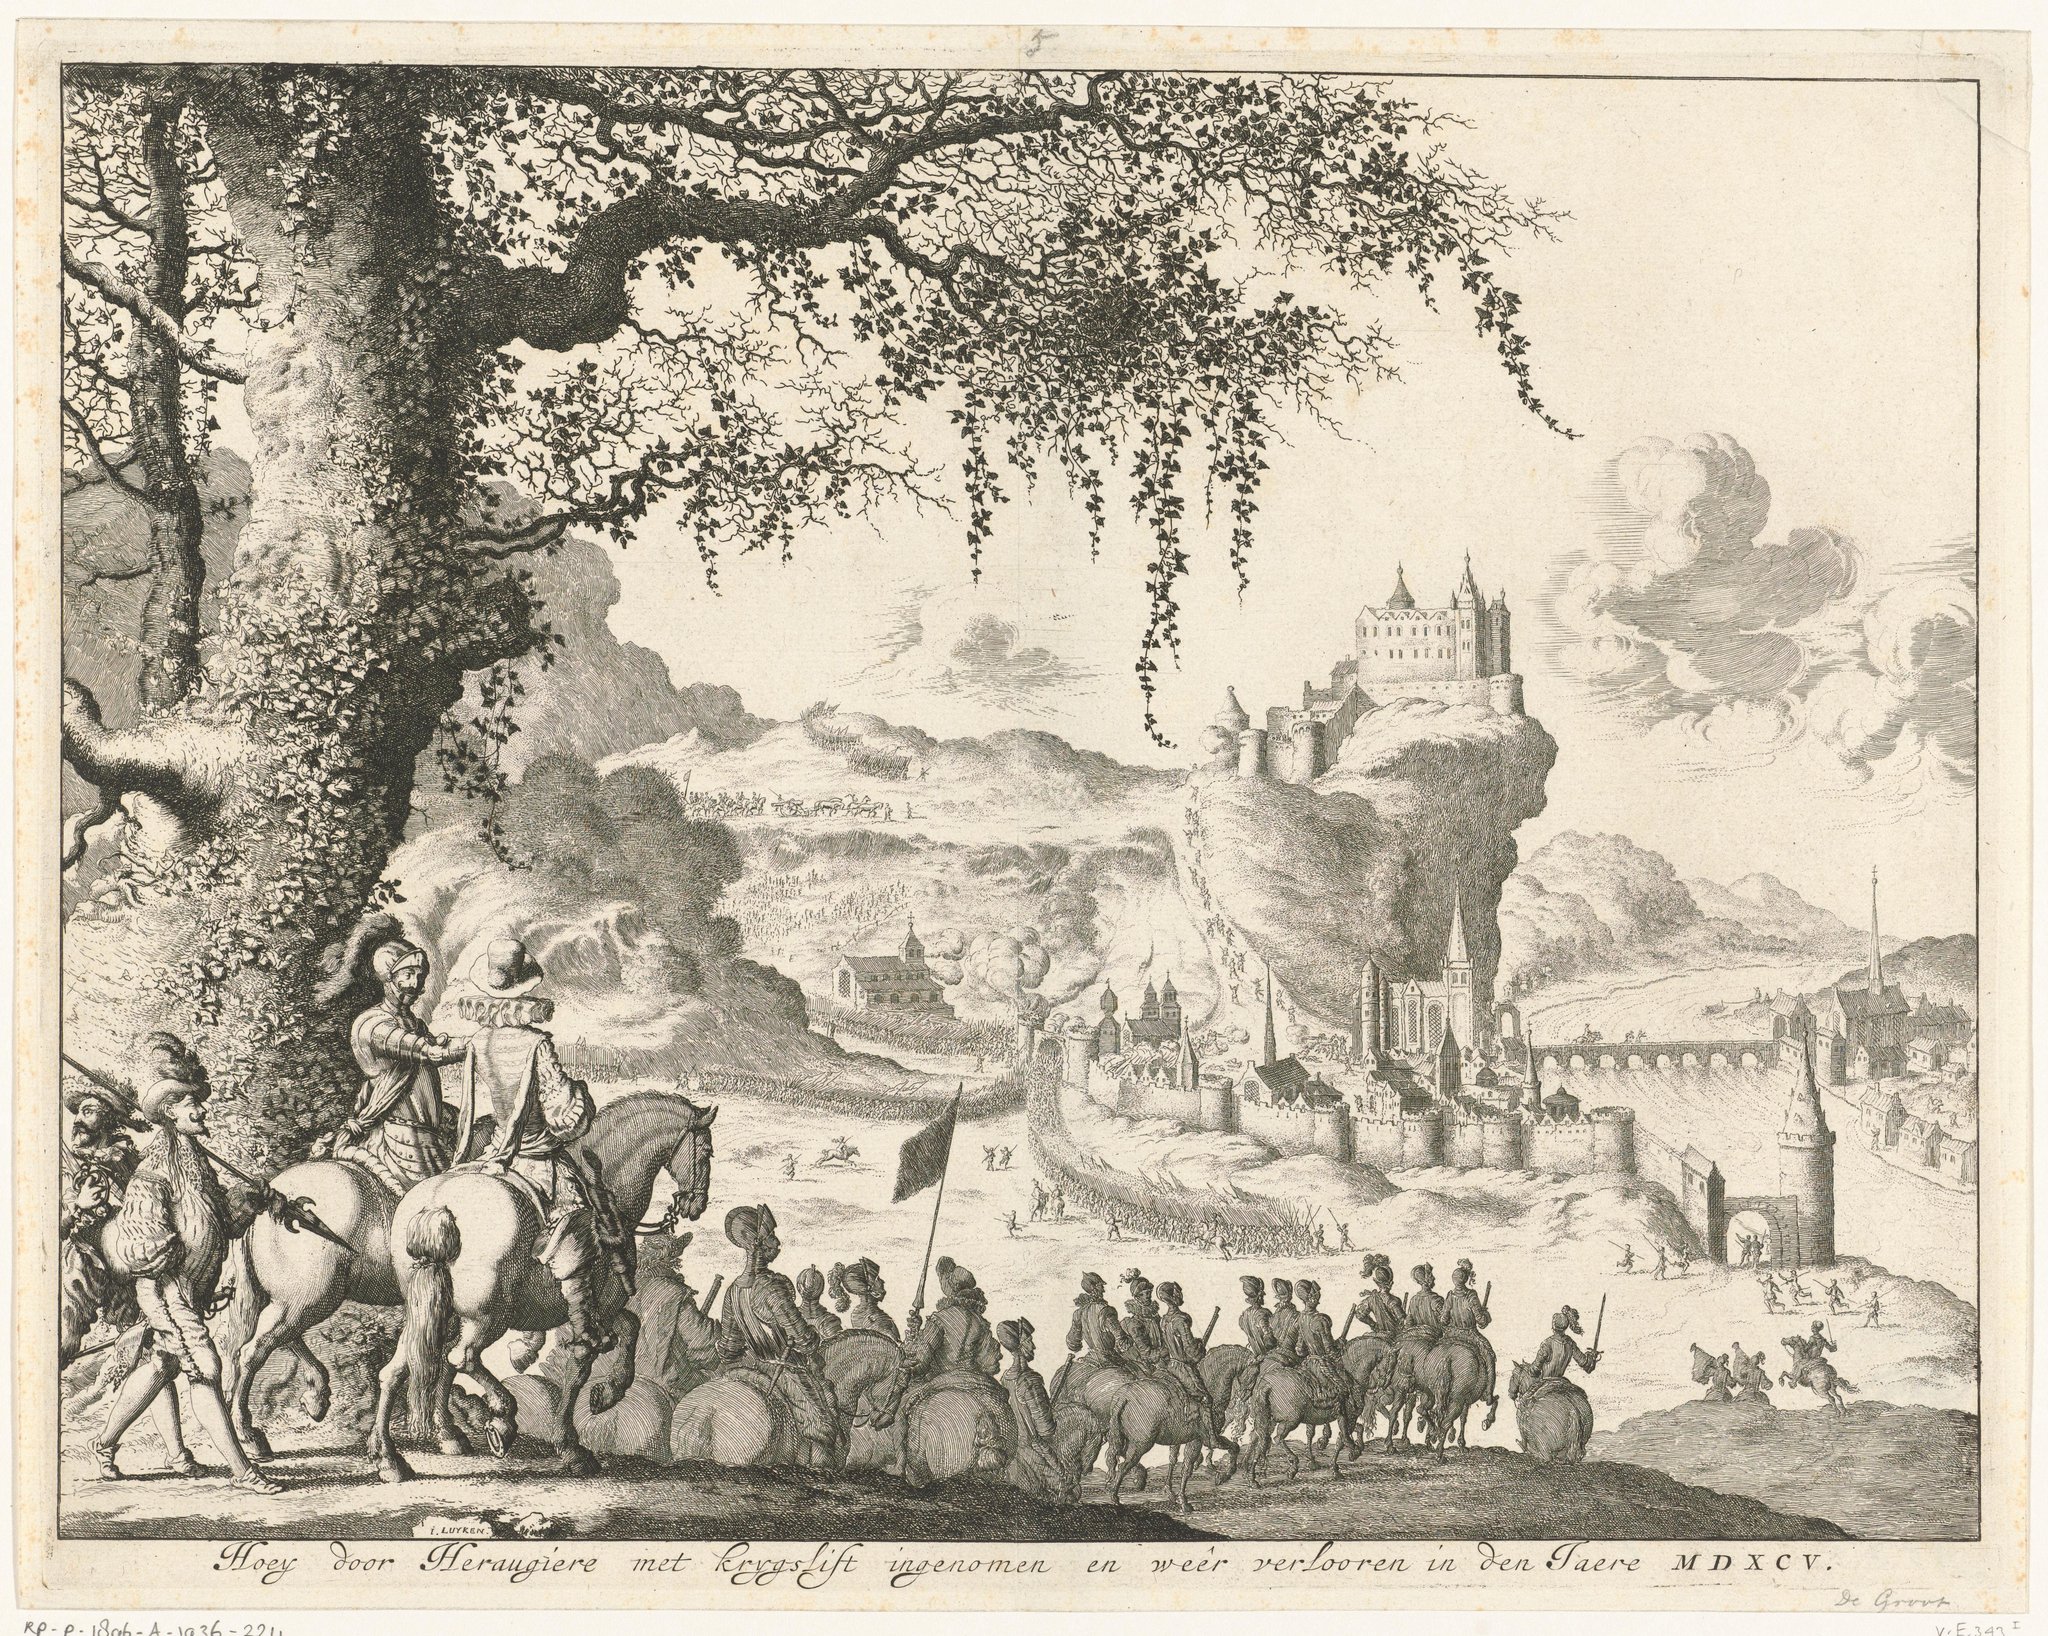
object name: print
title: Hoey door Haugière met krygslist ingenomen en weêr verlooren in den Jaere MDXCV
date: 1681-1684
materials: paper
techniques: etching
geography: amsterdam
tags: capture of city (after the siege)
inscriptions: collector's mark: Lugt 2228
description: Gebruikt als illustratie in: Bor Christiaansz, Pieter. Oorsprongk, begin, en vervolgh der Nederlandsche oorlogen, 4 delen, dl. IV (1684), p. 10. Amsterdam: weduwe Joannes van Someren, Abraham Wolfgang, Hendrick en Dirk Boom, 1679-1684. Tevens in: Groot, Hugo de. Nederlandtsche Jaerboeken en Historien. Amsterdam: weduwe Joannes van Someren, Abraham Wolfgang, Hendrick en Dirk Boom, 1681, p. 322.